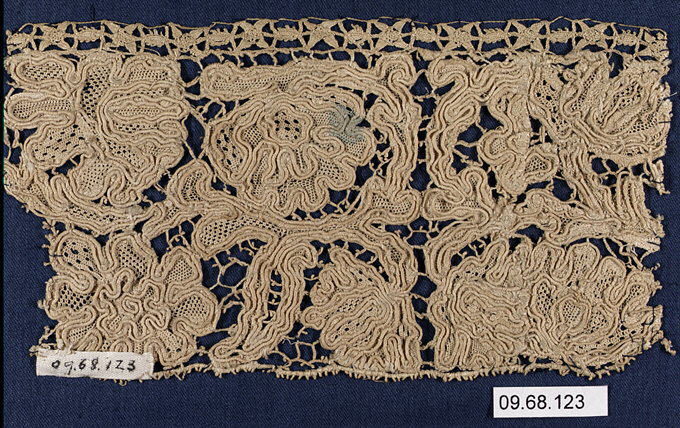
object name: needlepoint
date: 1601-1700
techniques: lace